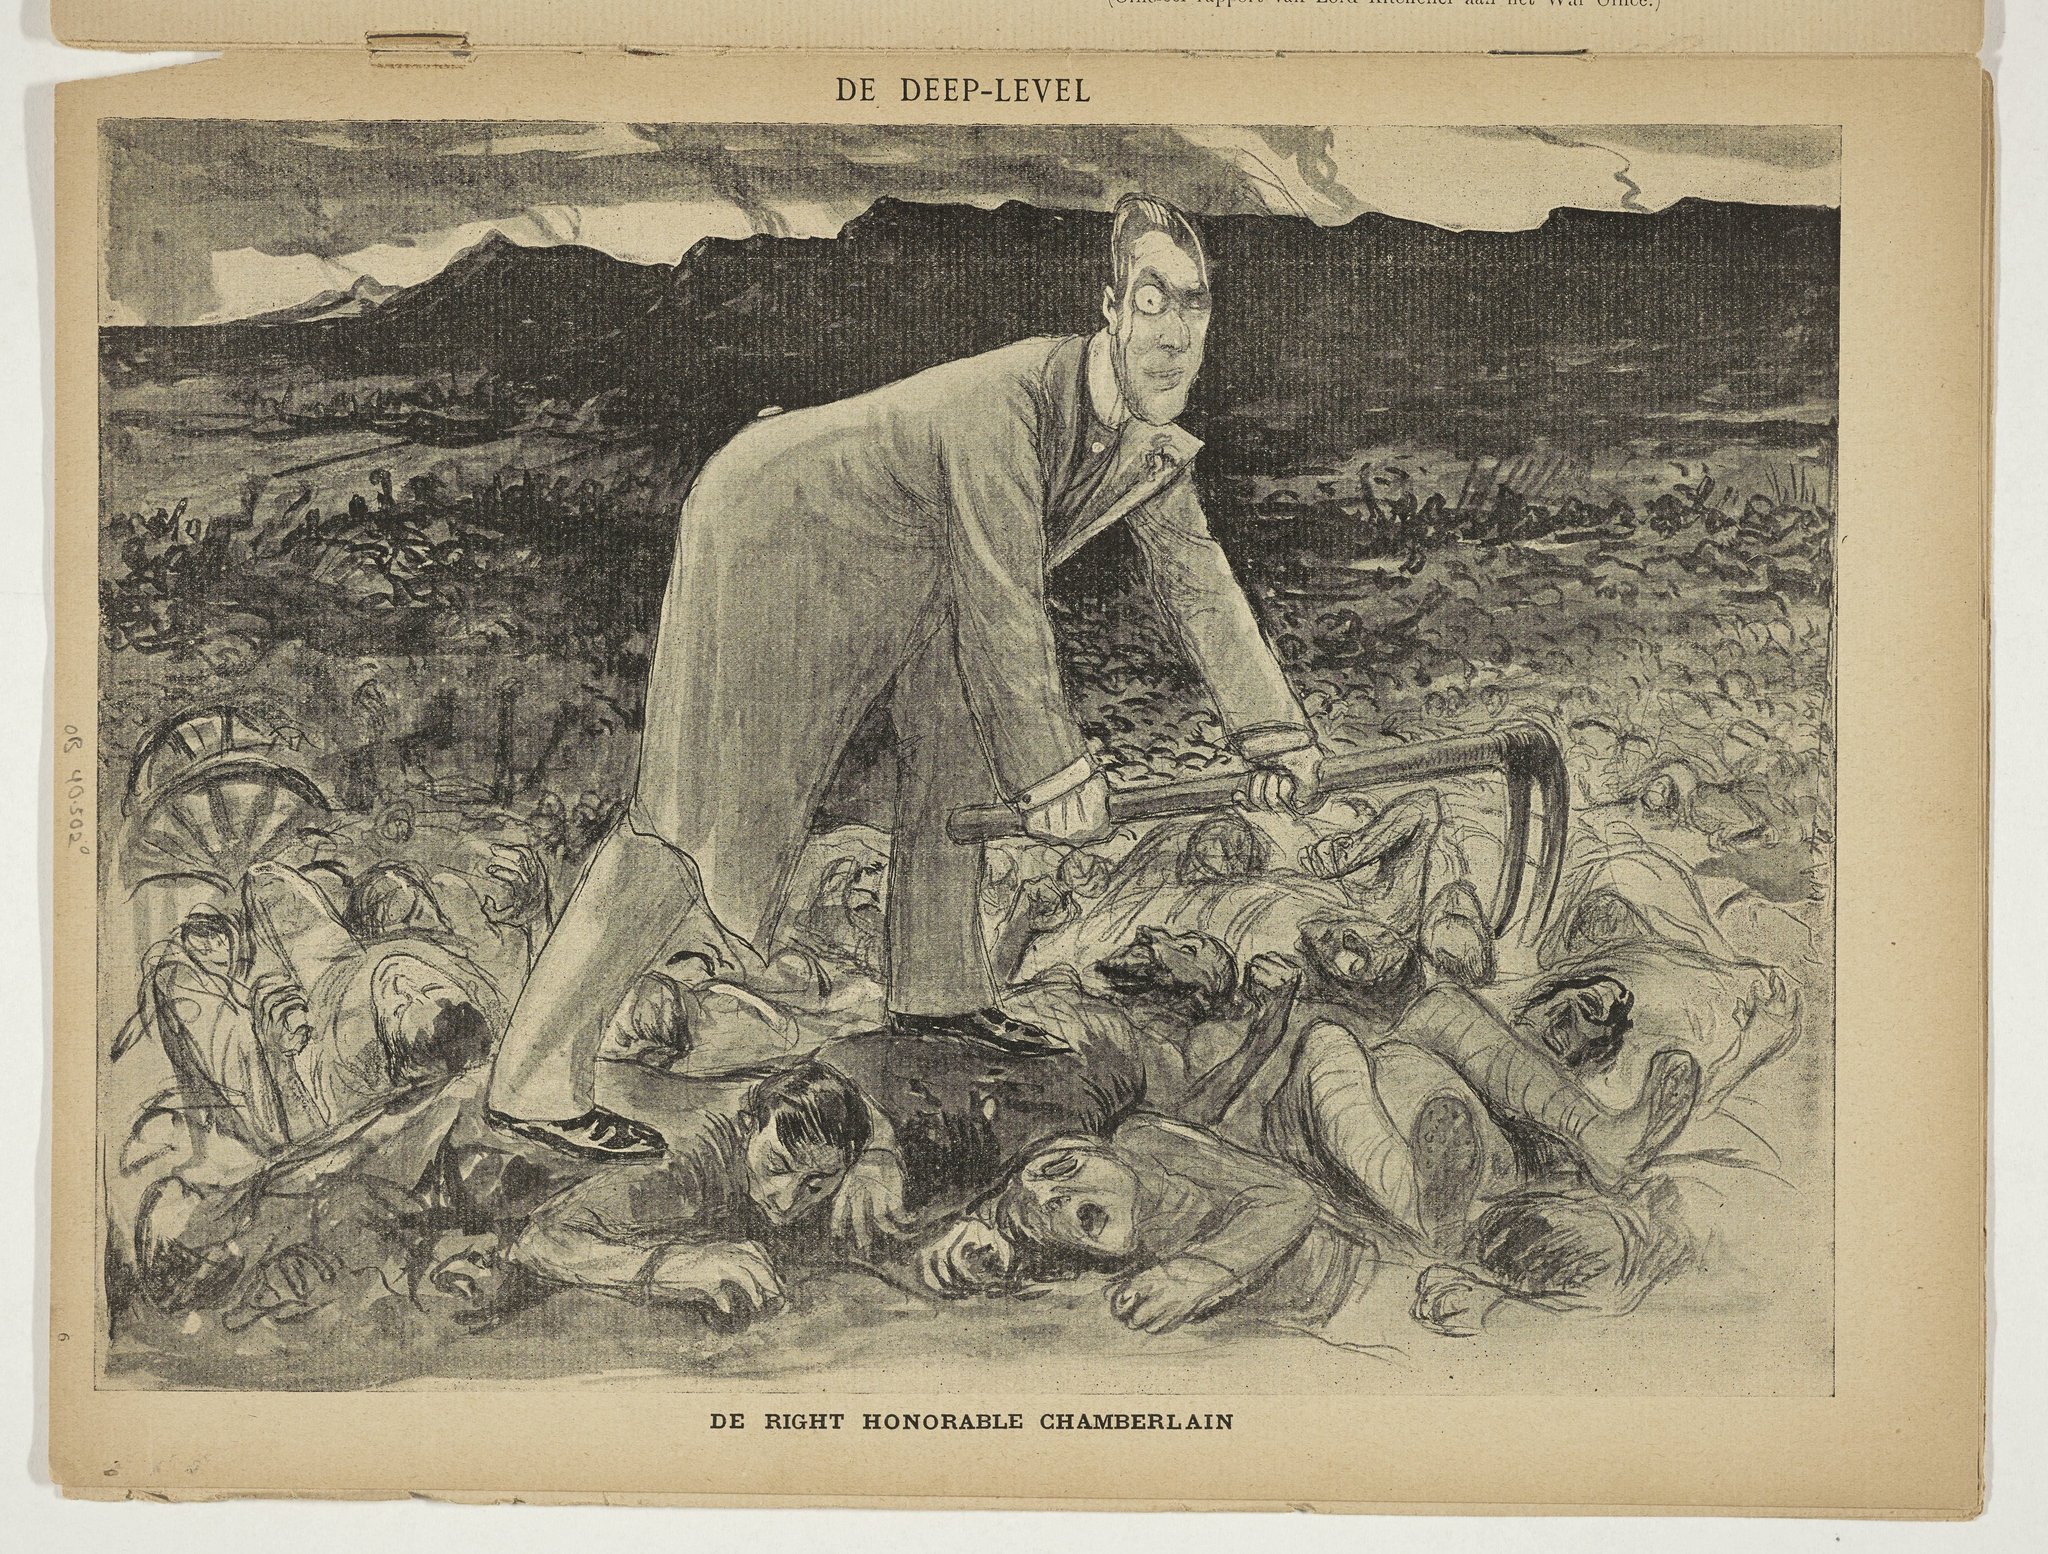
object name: photomechanical print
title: De deep-level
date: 1901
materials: paper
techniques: letterpress printing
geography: amsterdam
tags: politician, horrors of war, political caricatures and satires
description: Prent uit: De Boeren-Kampen / (Les camps de reconcentration), 1901. Dit is de geautoriseerde Nederlandse uitgave van: L'Assiette au Beurre 1 (1901), nr. 26 (Les camps de reconcentration au Transvaal), 28 september 1901.